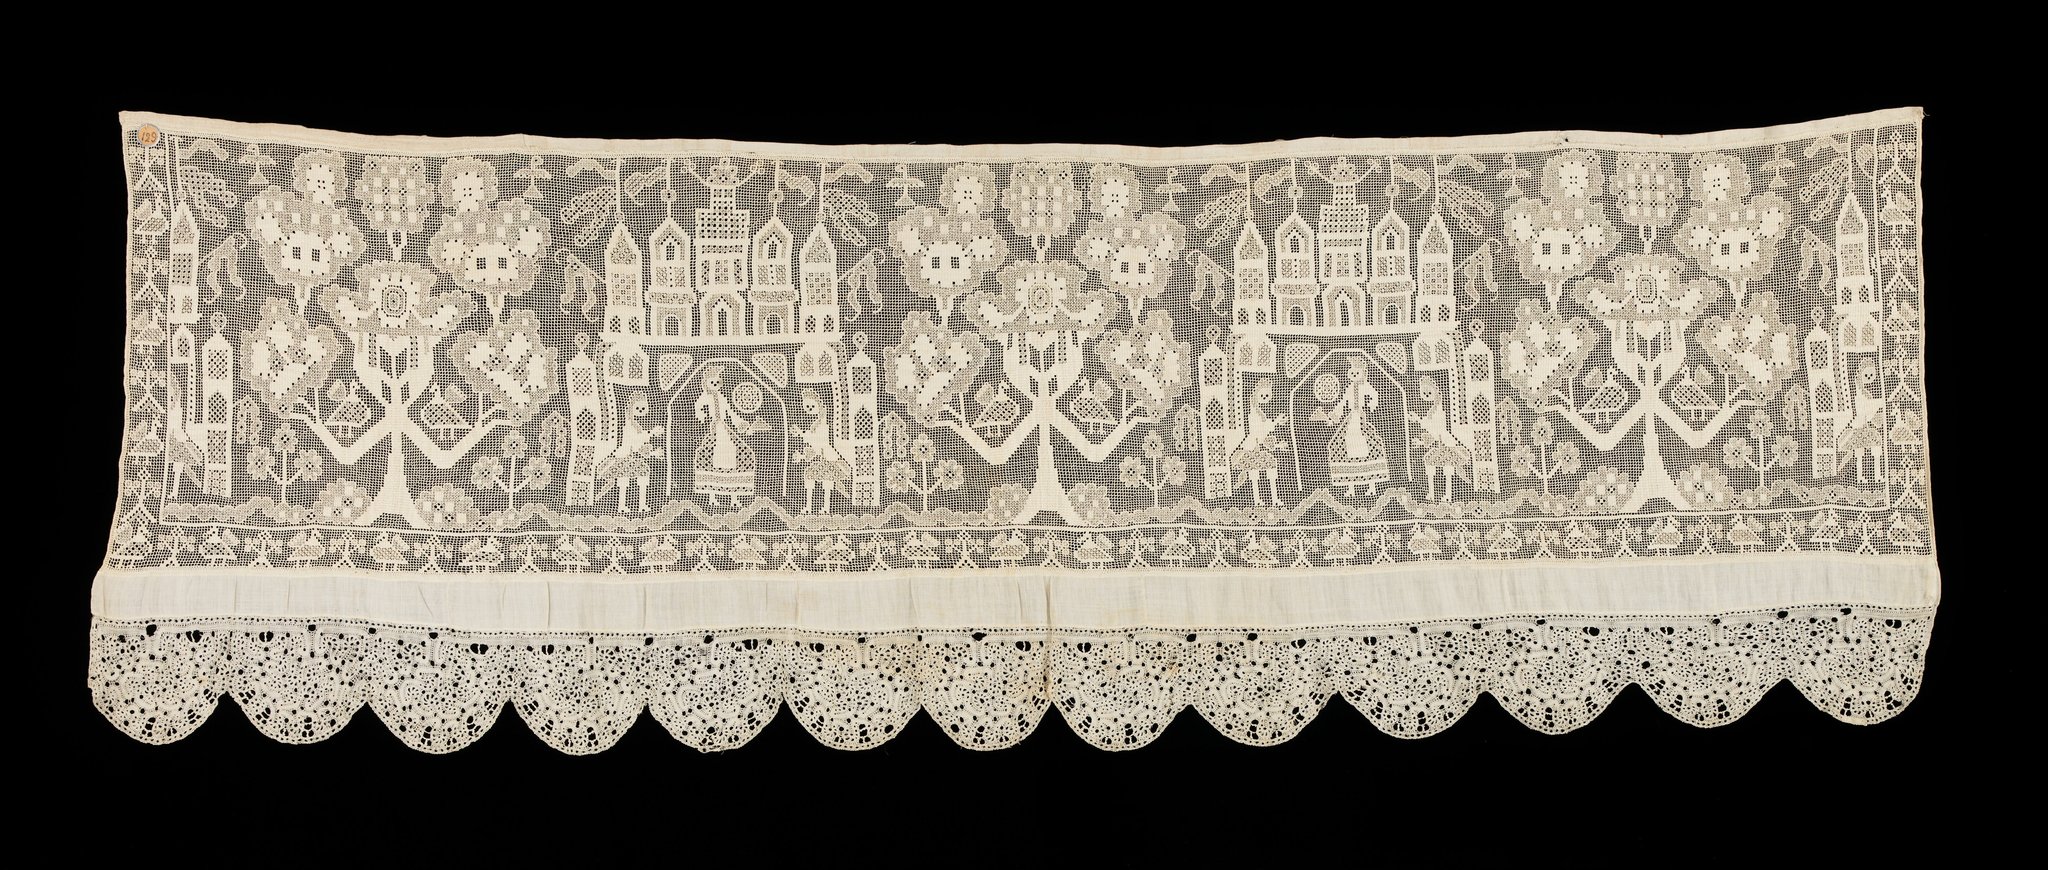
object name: border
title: Bed curtain border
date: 1801-1825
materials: linen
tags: buildings,men,women,trees